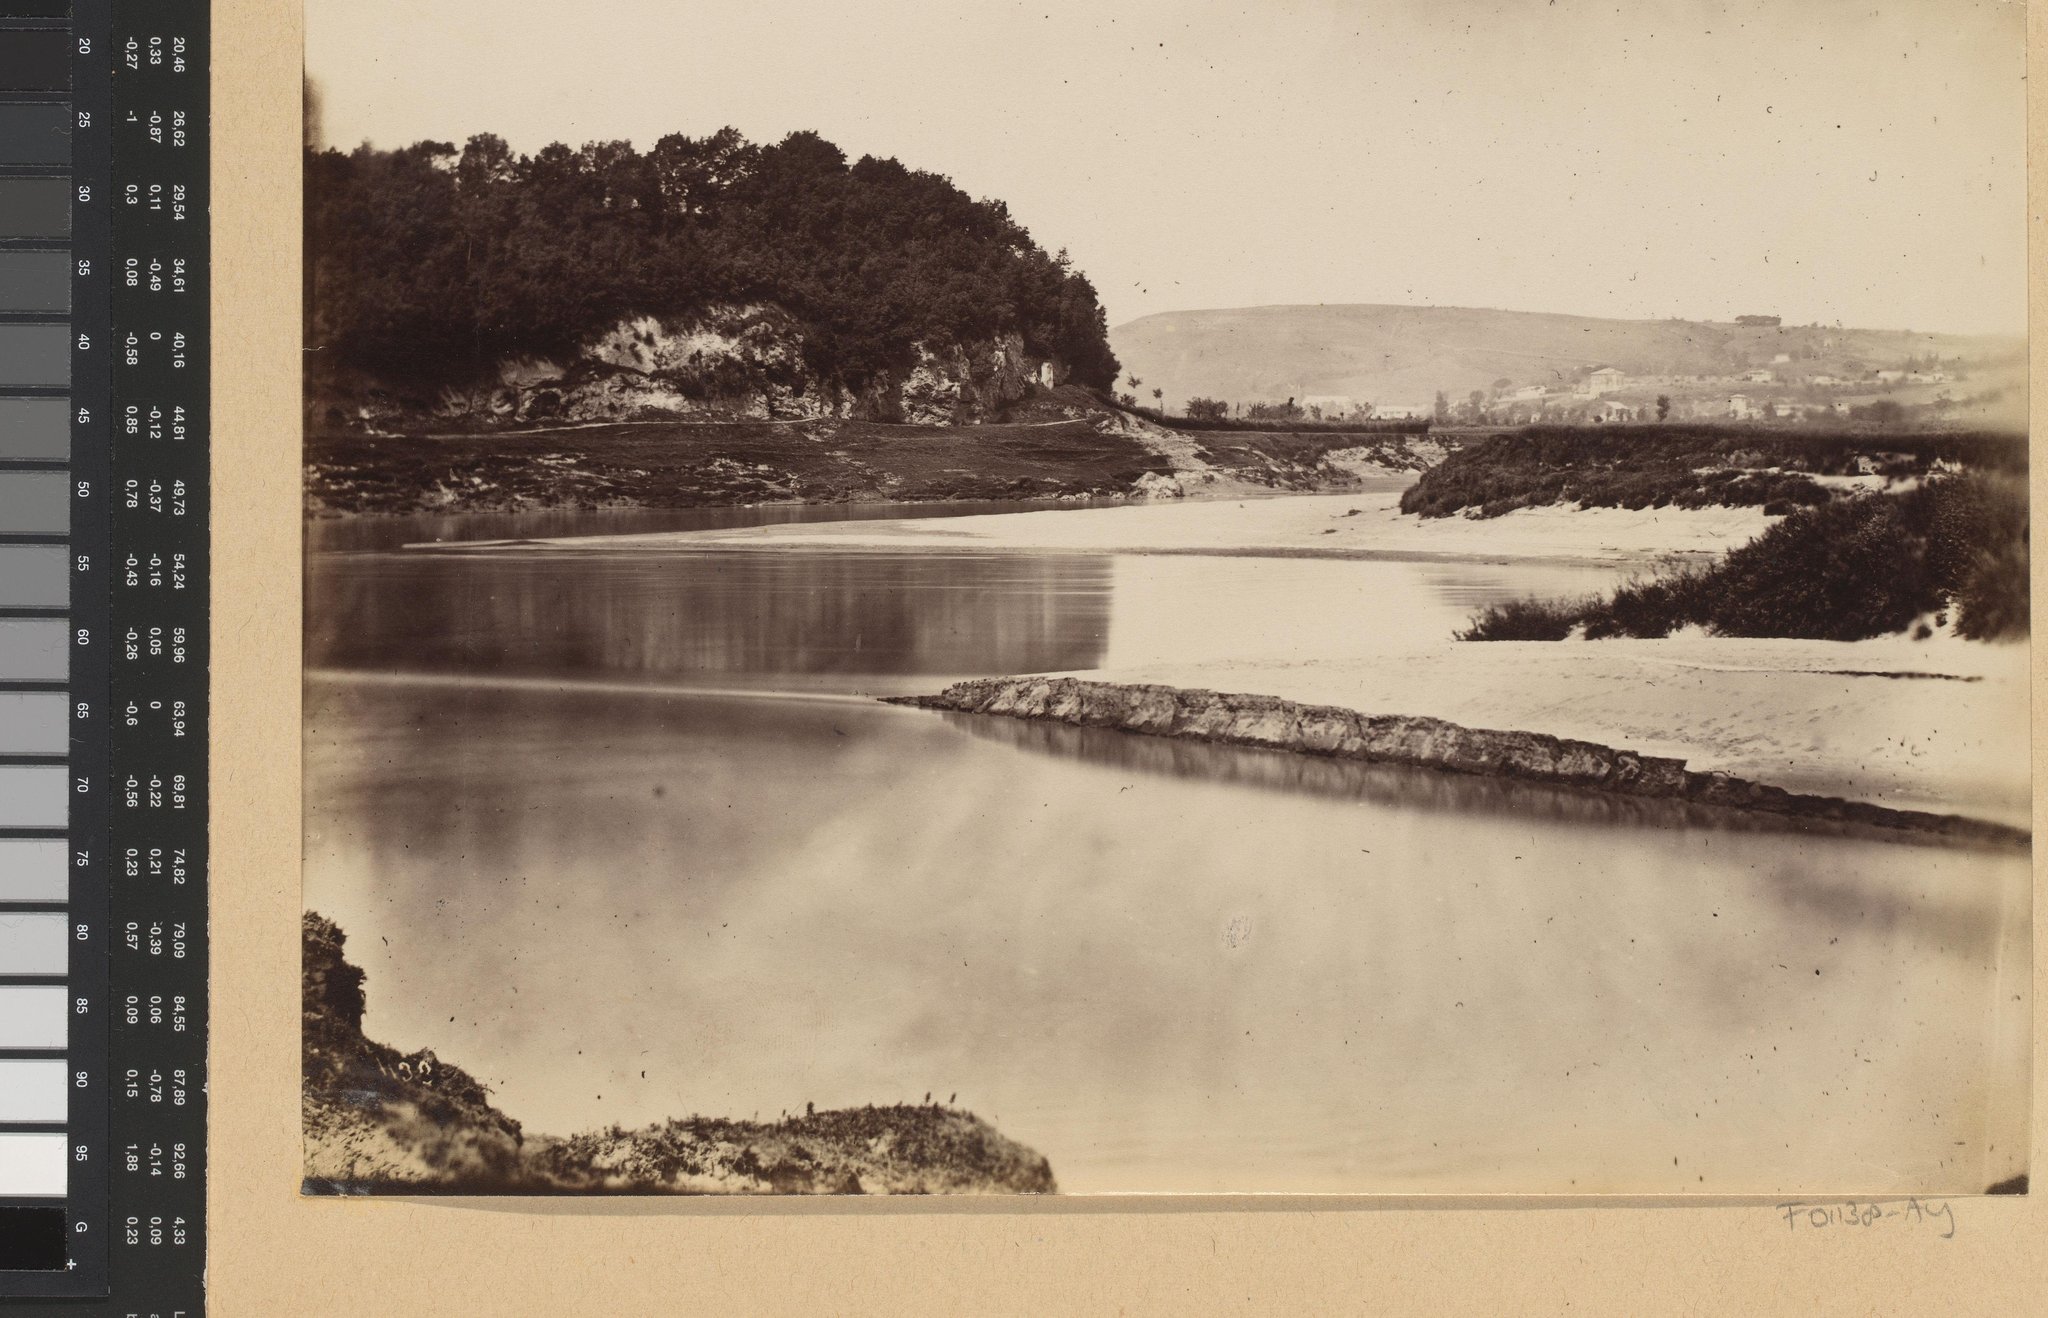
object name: photograph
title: Landschap met rivier, vermoedelijk in Italië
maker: Anonymous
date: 1860-1880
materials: photographic support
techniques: albumen print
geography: italy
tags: river (+ landscape with figures, staffage), italy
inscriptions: number: ‘[...]32’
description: Onderdeel van Reisalbum met opnames van kunstwerken en bezienswaardigheden in Italië, Griekenland en Frankrijk.